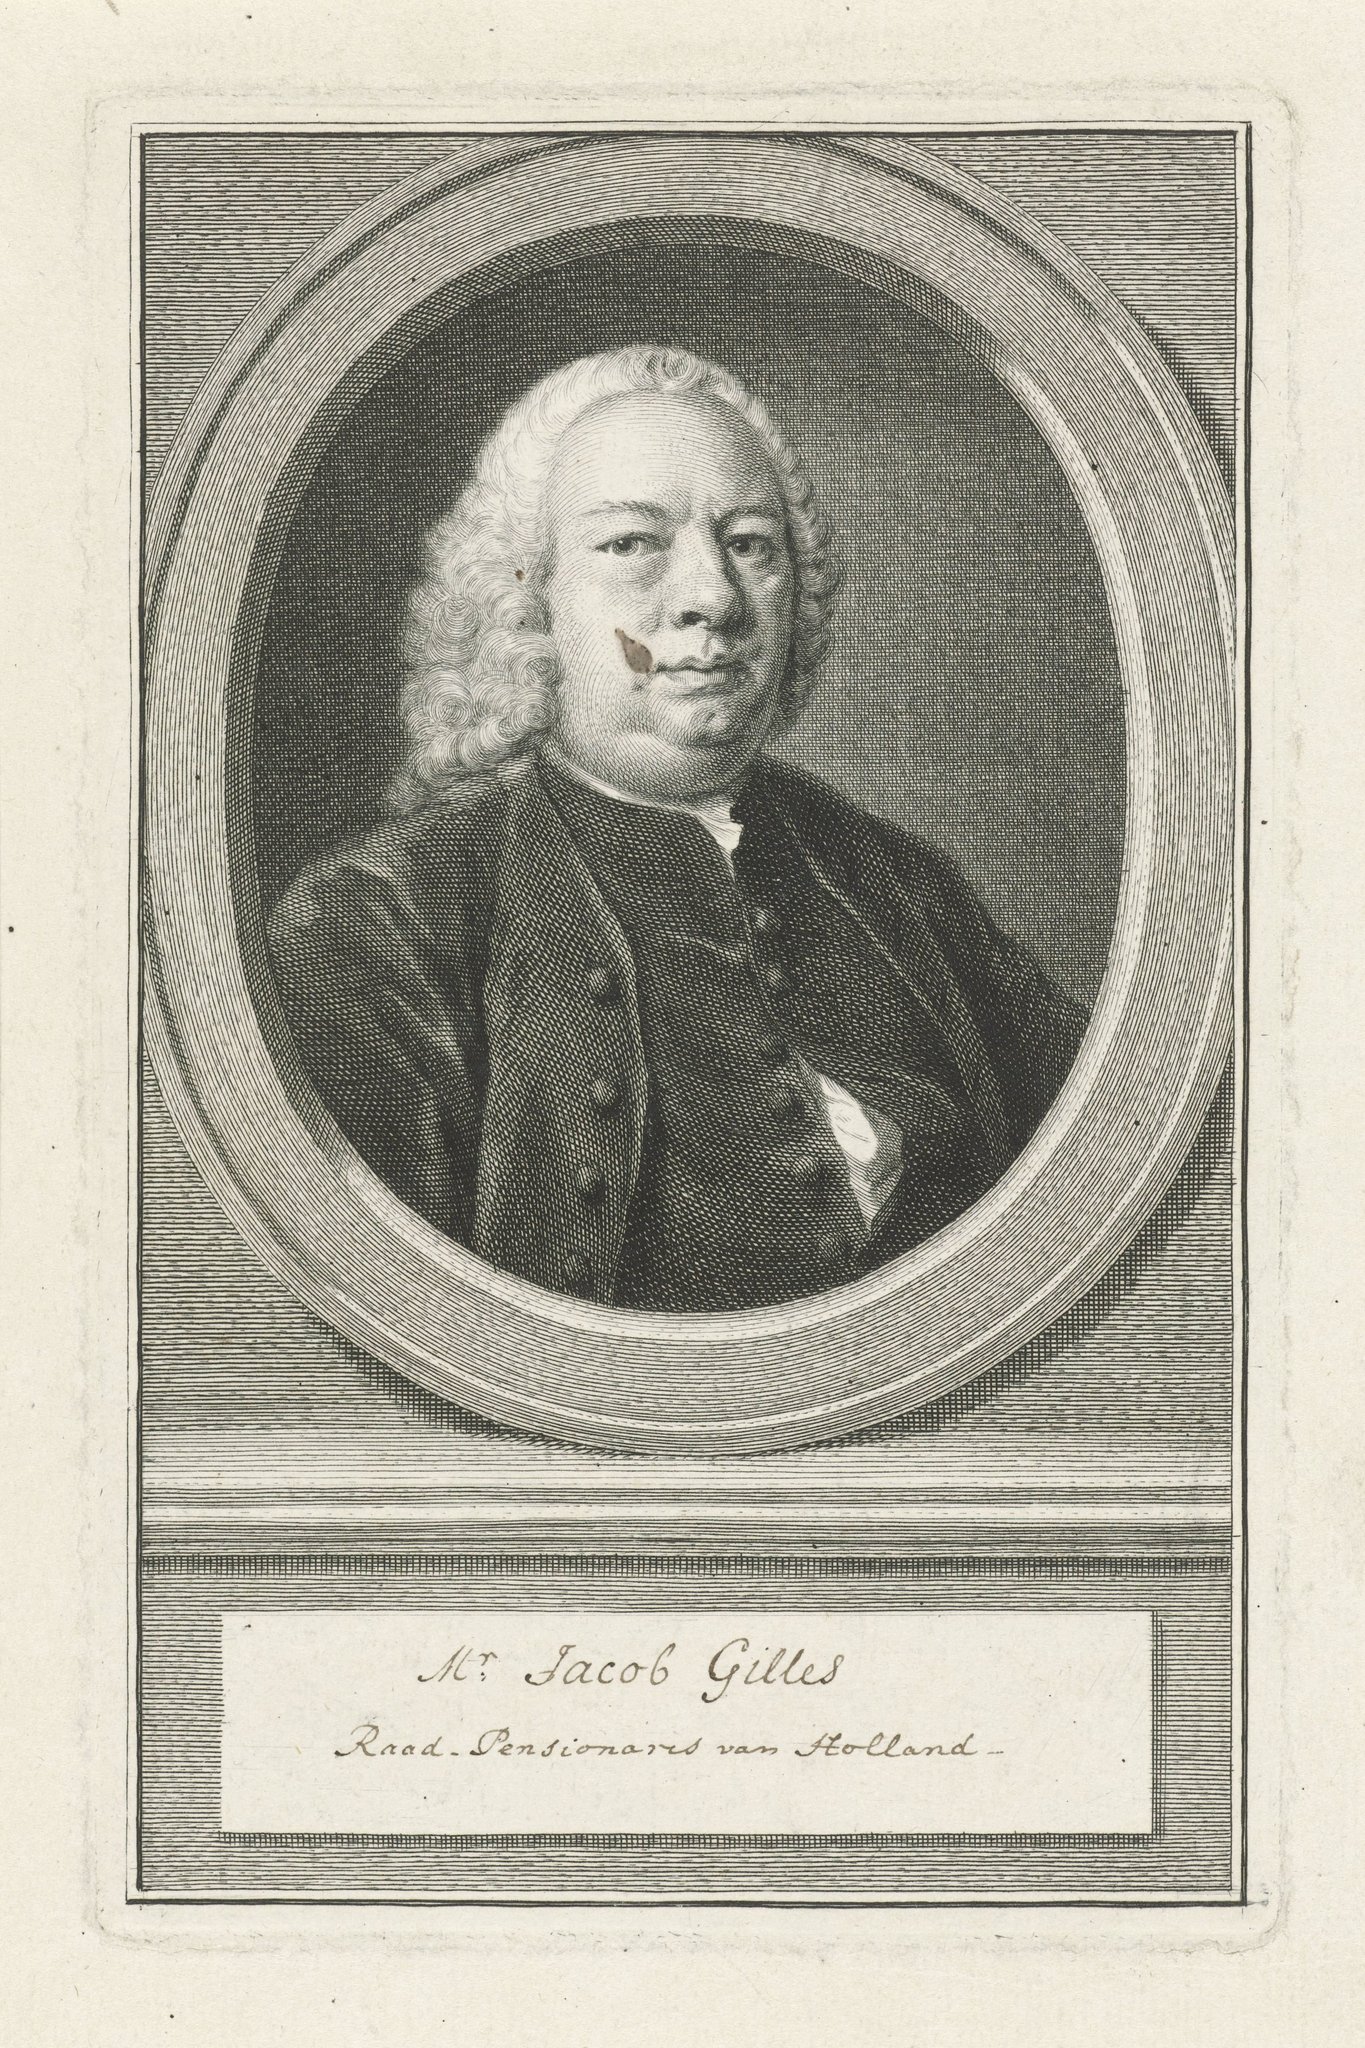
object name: print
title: Portret van Jacob Gilles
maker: jacob houbraken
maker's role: draughtsman, print maker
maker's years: 1698-1780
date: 1747-1759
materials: paper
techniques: engraving, pen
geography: amsterdam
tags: kollum, rijswijk, raadpensionaris, jacob gilles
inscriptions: inscription: ‘Mr. Jacob Gilles/ Raad-Pesionaris van Holland’, collector's mark: Lugt 2228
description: Proefdruk van de prent gebruikt in: Jan Wagenaar, Vaderlandsche historie, vervattende de geschiedenissen der nu Vereenigde Nederlanden, inzonderheid die van Holland (...), 21 delen. Amsterdam, Isaak Tirion, 1749-59.